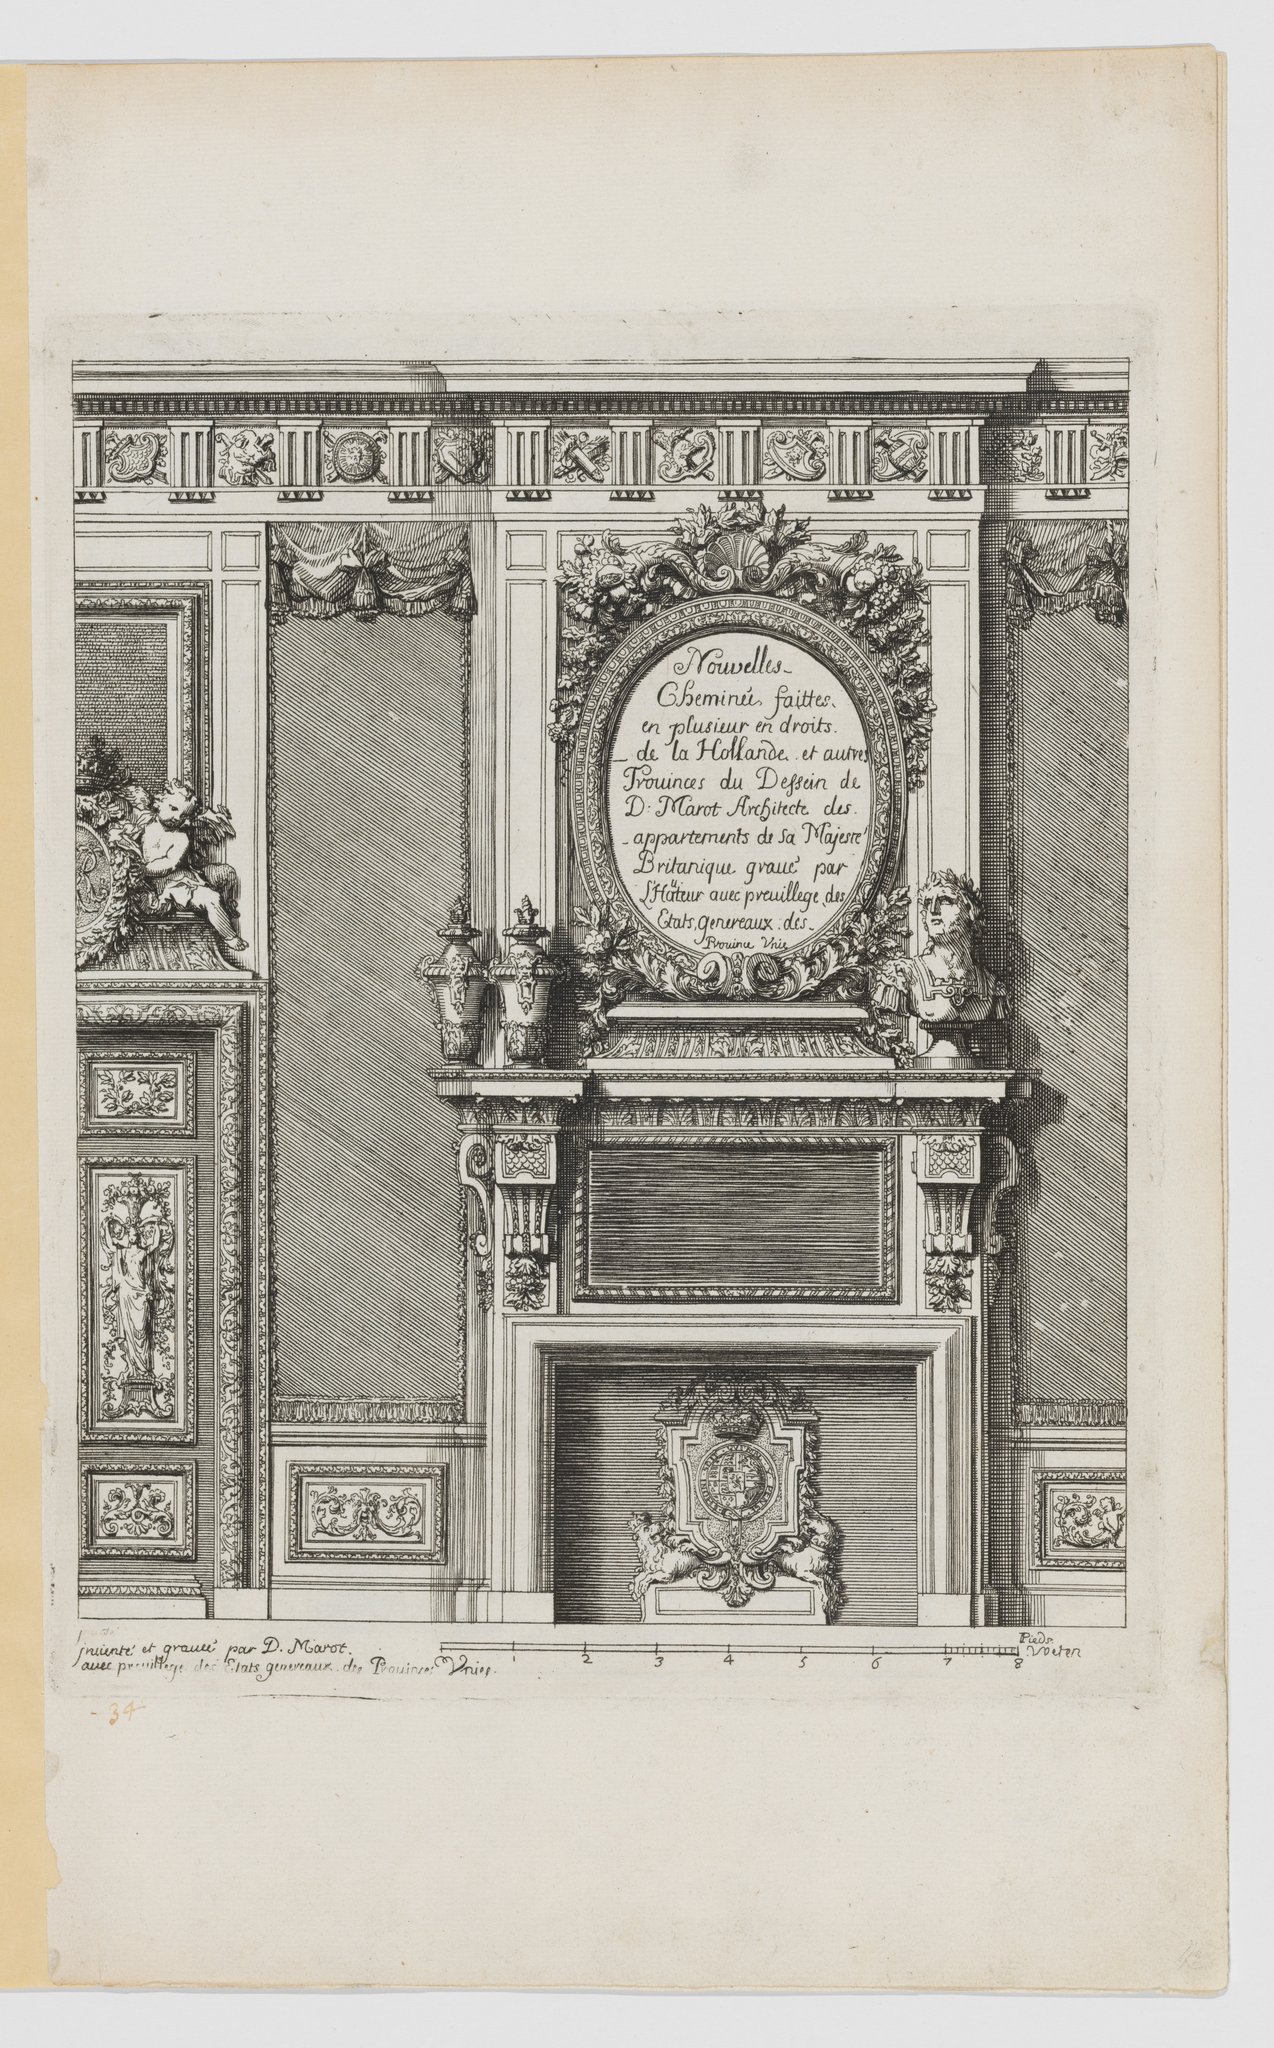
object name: print collection ornament architecture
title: Title Plate with Design for a Chimney, from Nouvelles Cheminées Faittes en Plusieur en Droits de la Hollande et Autres Prouinces, part of Œuvres du Sr. D. Marot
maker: daniel marot the elder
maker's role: artist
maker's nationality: french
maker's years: 1661-1752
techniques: etching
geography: netherlands